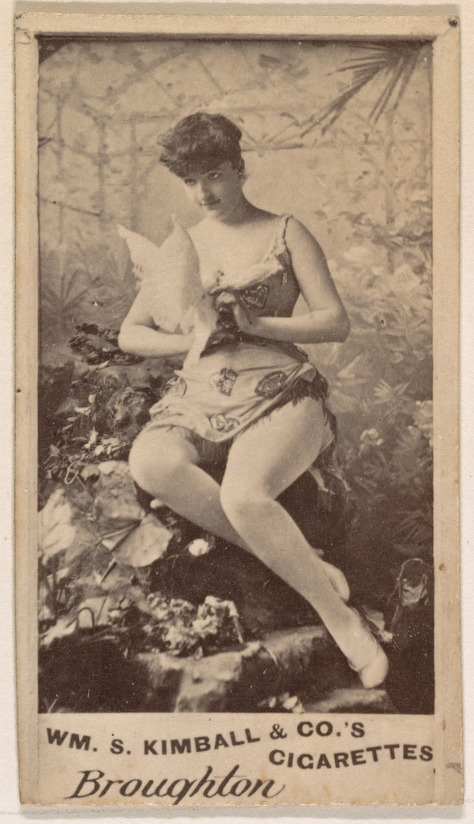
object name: photograph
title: Miss Broughton, from the Actresses series (N203) issued by Wm. S. Kimball & Co.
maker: william s. kimball & company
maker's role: publisher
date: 1889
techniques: color lithograph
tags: birds,portraits,women,actresses